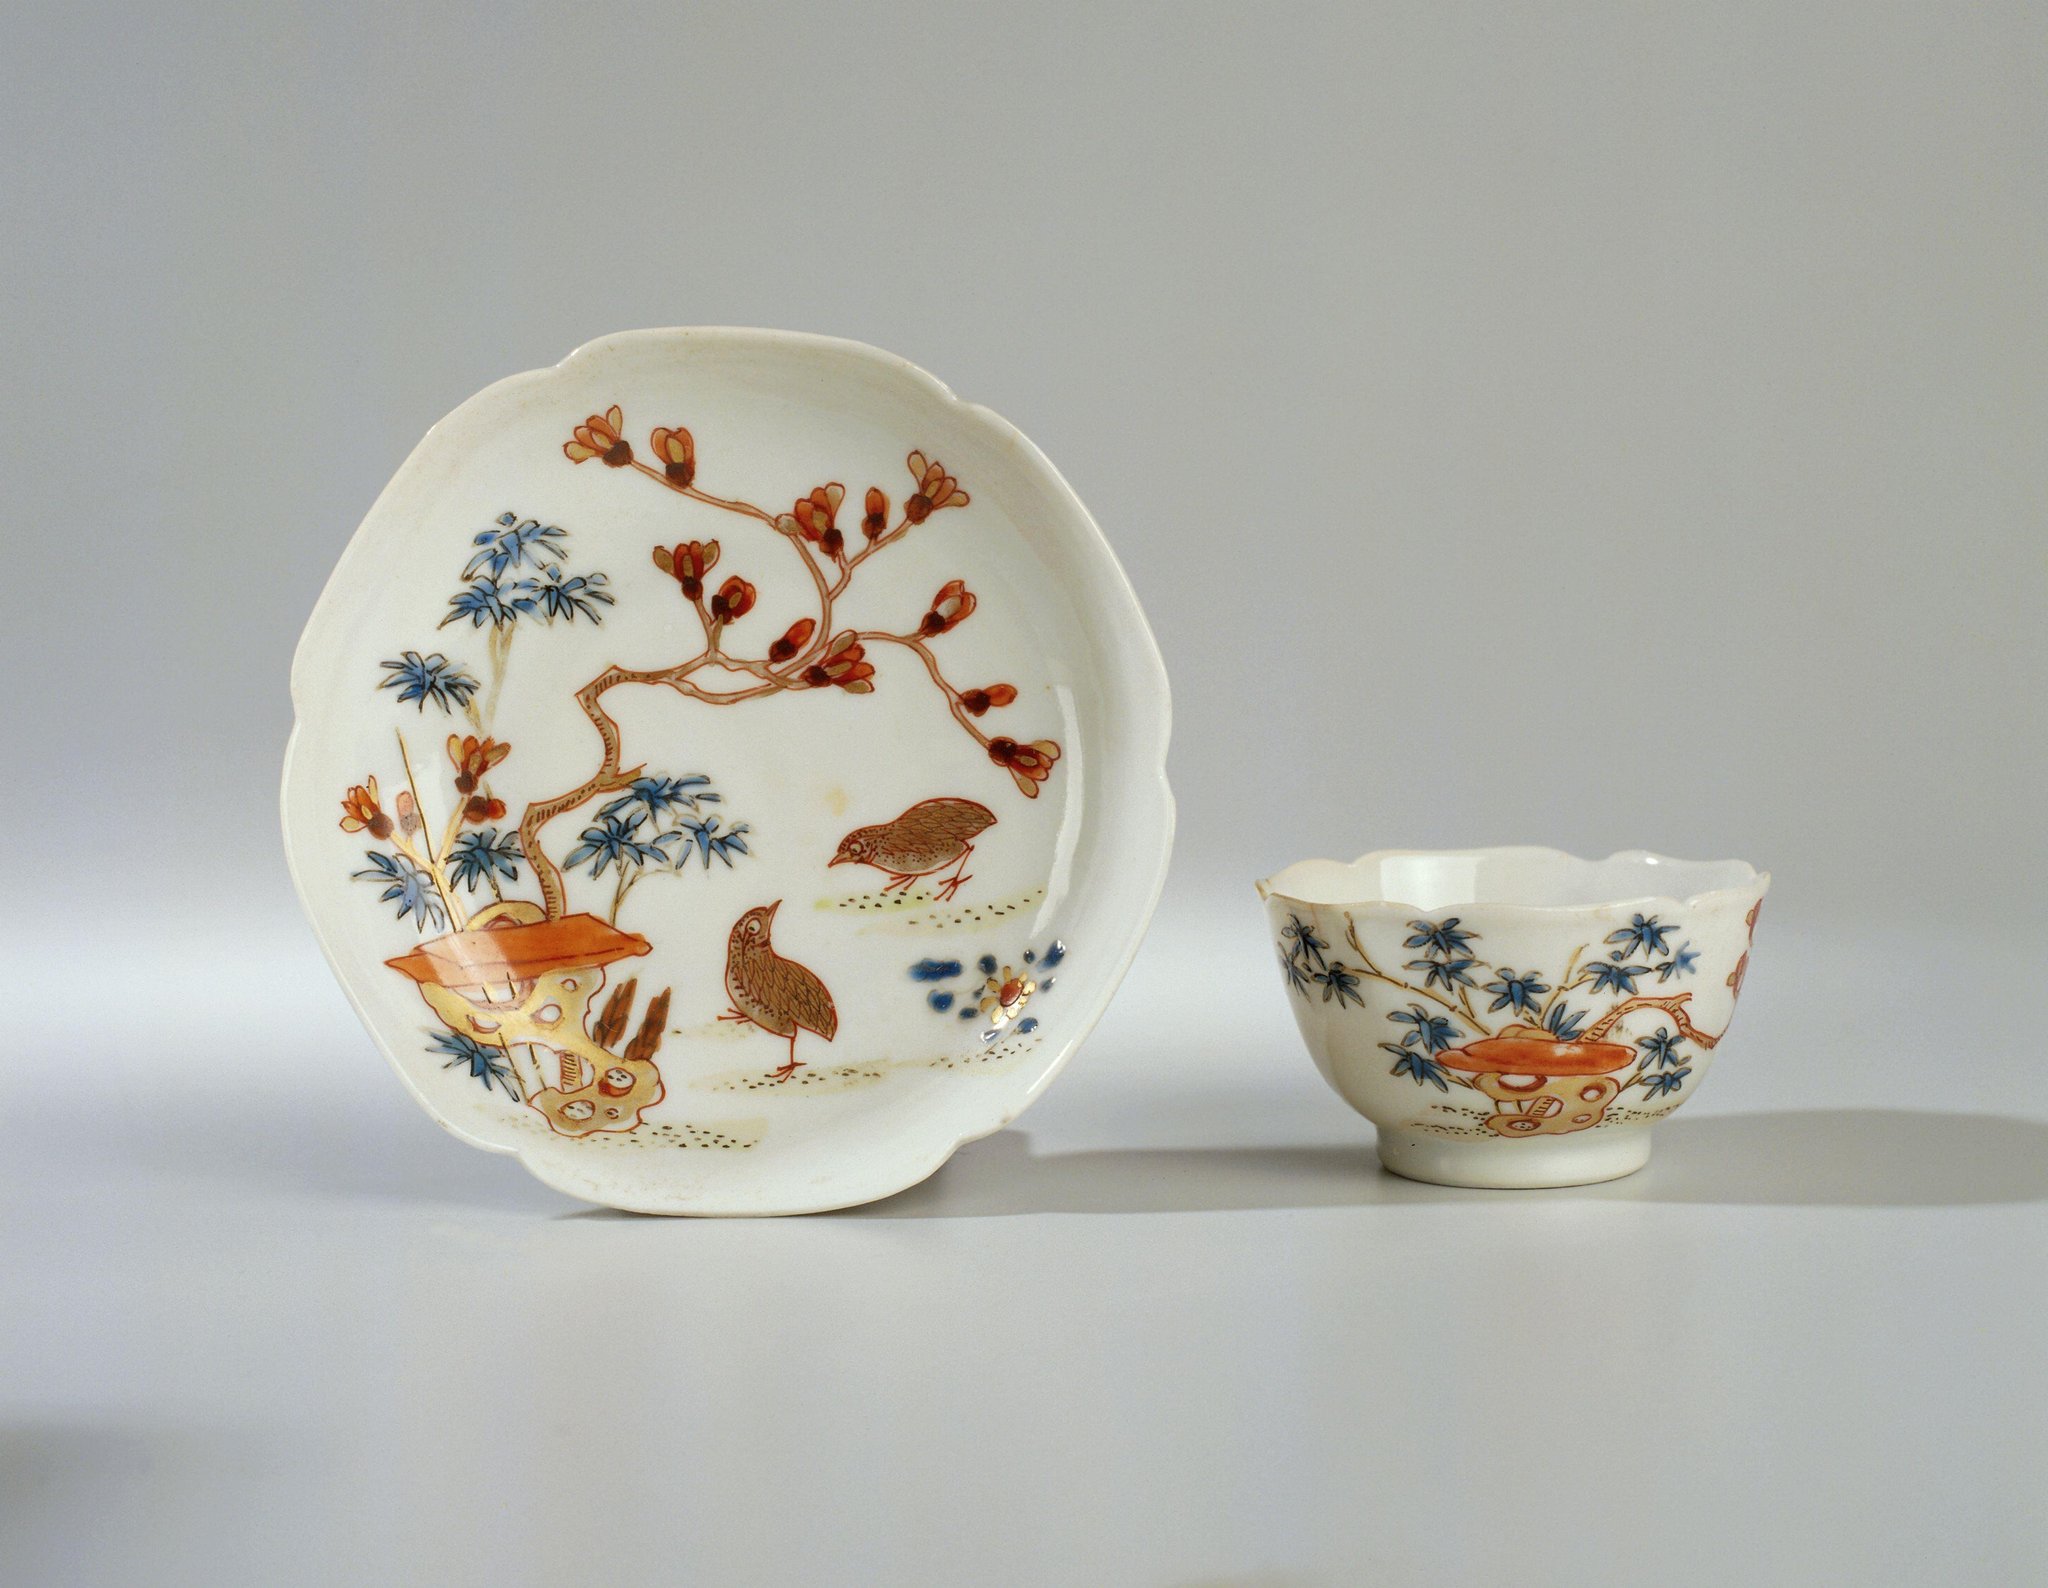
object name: platter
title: Saucer with two quail near a rock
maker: Anonymous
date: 1725-1749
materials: glaze, gold, paint, porcelain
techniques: firing, gilding, turning, vitrification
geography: china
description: Schotel van porselein met een zesmaal ingeknepen rand, beschilderd op het glazuur in blauw, rood, groen, zwart en goud. Op het plat twee kwartels bij een rots met een magnolia en bamboe. Porselein met emailkleuren.